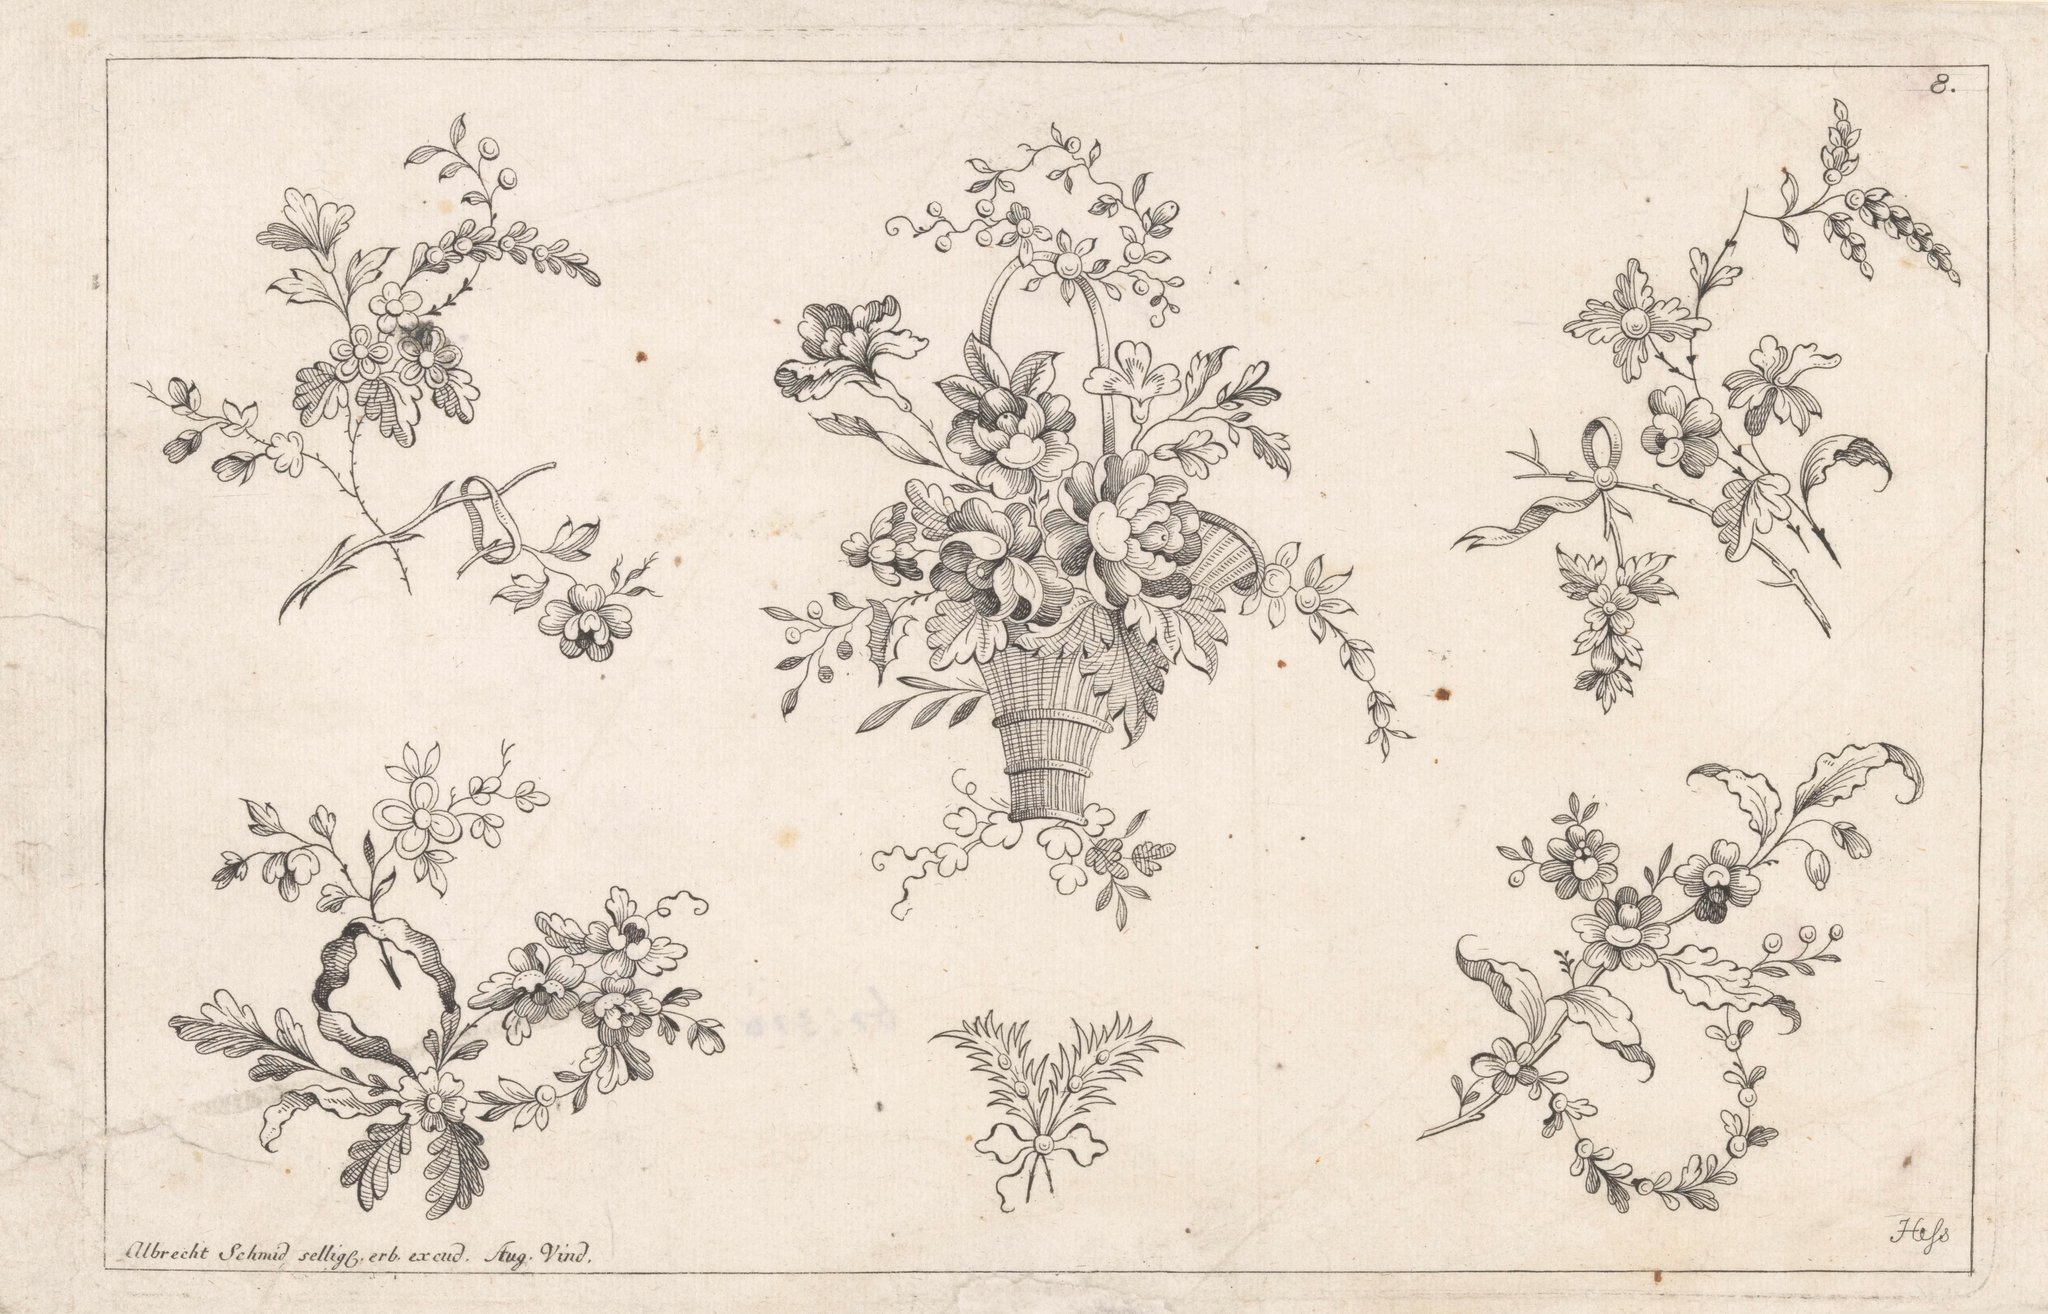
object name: print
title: 2. Theil. Allerlei Bouquets Blumen und Streifen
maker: gottlieb hess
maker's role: publisher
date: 1744-1800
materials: paper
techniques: etching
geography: augsburg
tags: flowers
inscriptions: collector's mark: Lugt 2228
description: Ontwerpen voor diverse bloemen. In het midden een mand met bloemen.